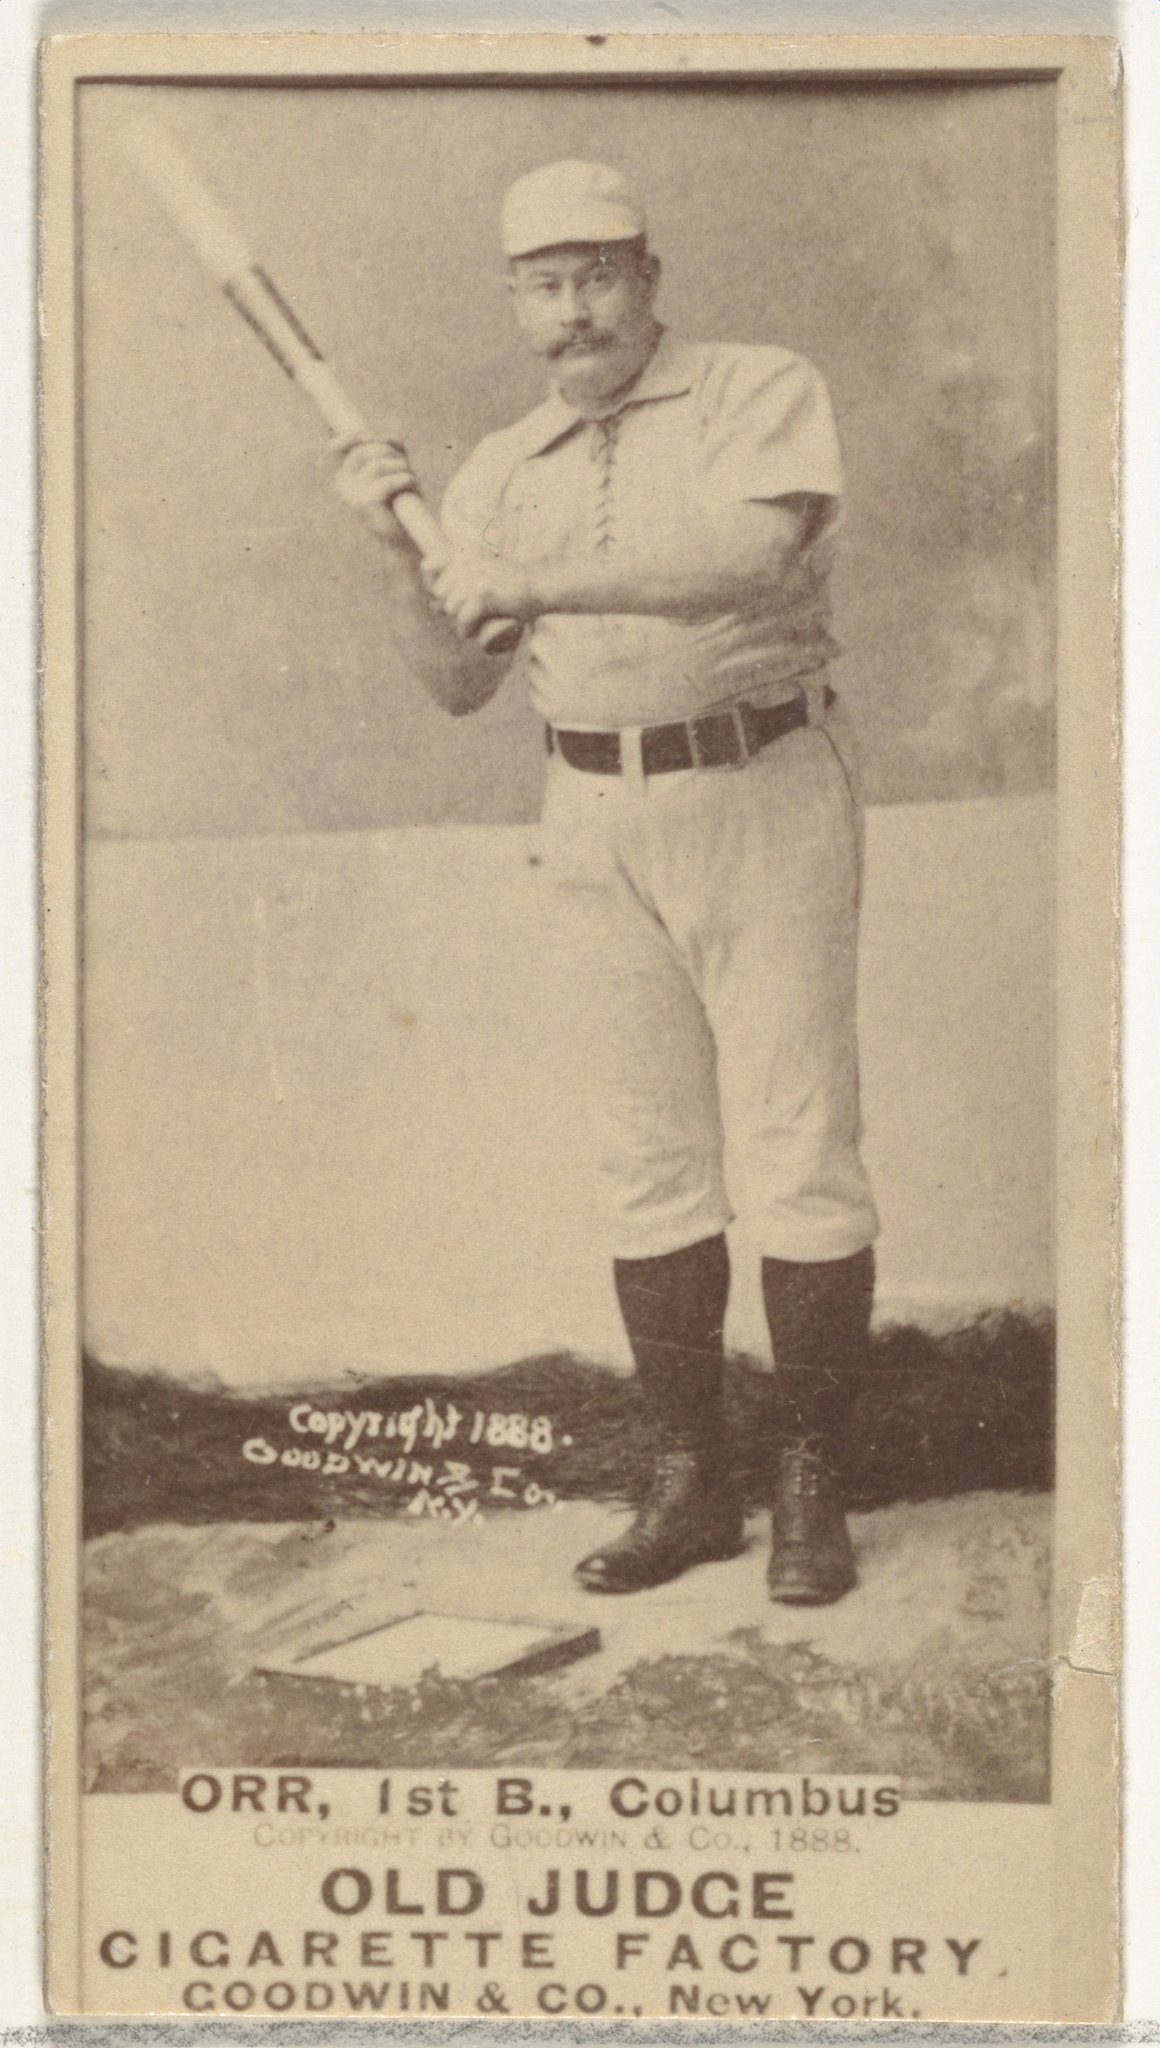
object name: baseball card, photograph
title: David L. "Dave" Orr, 1st Base, Cleveland, from the Old Judge series (N172) for Old Judge Cigarettes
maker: goodwin & company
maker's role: publisher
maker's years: 1850-1950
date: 1888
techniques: albumen silver print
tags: men,portraits,baseball,athletes